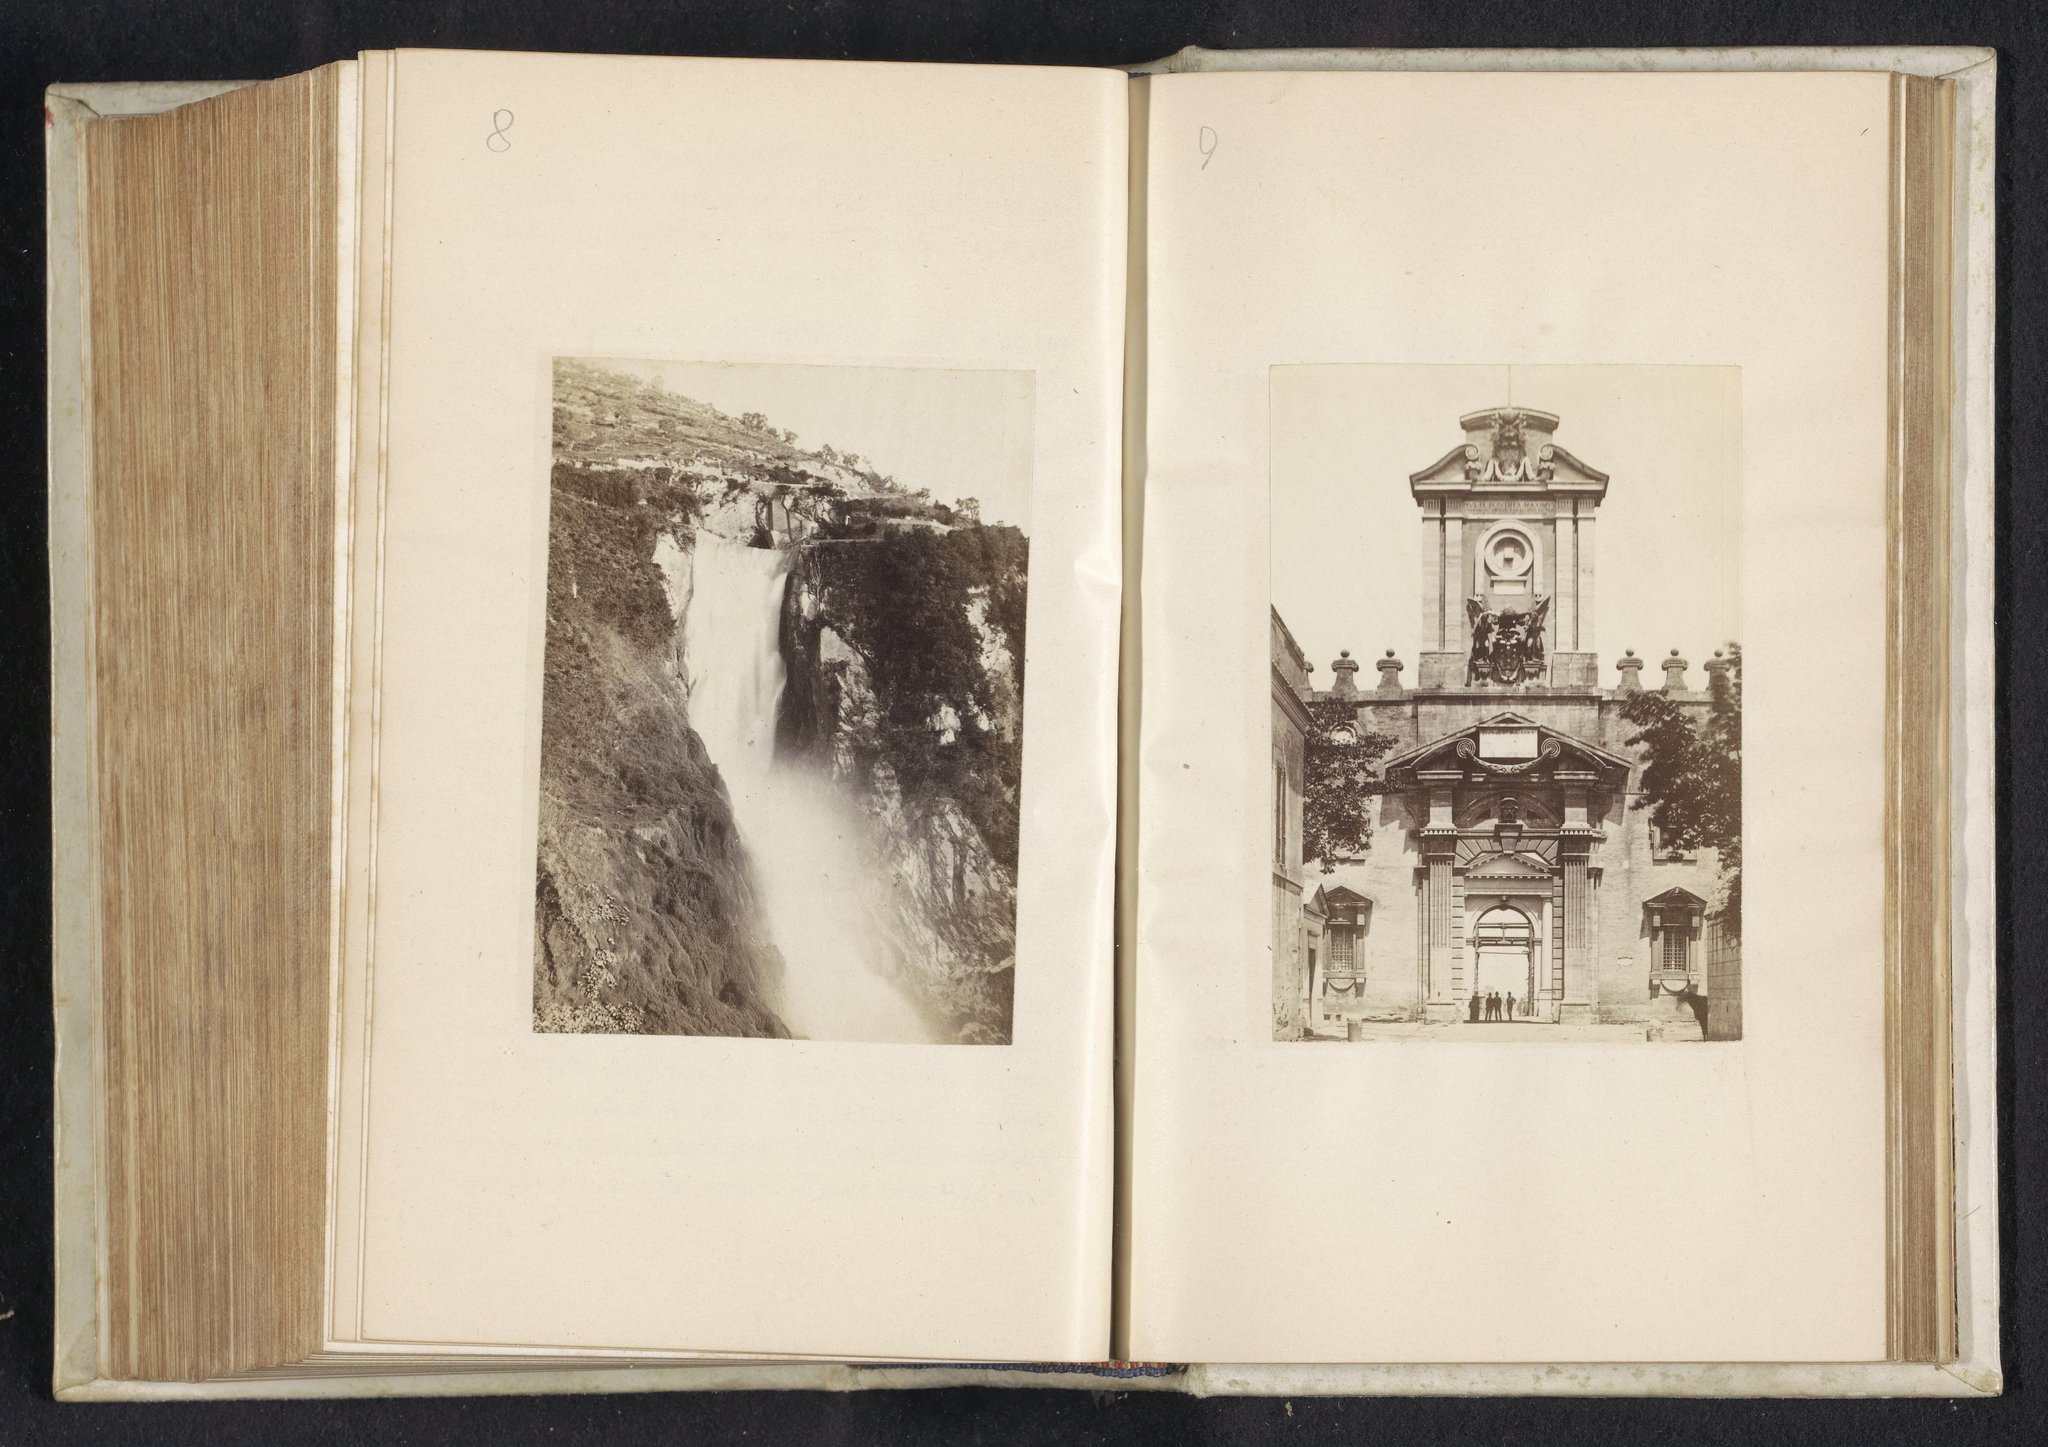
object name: photograph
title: Gezicht op een waterval te Italië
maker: Anonymous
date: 1850-1860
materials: photographic support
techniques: albumen print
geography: italy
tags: waterfall